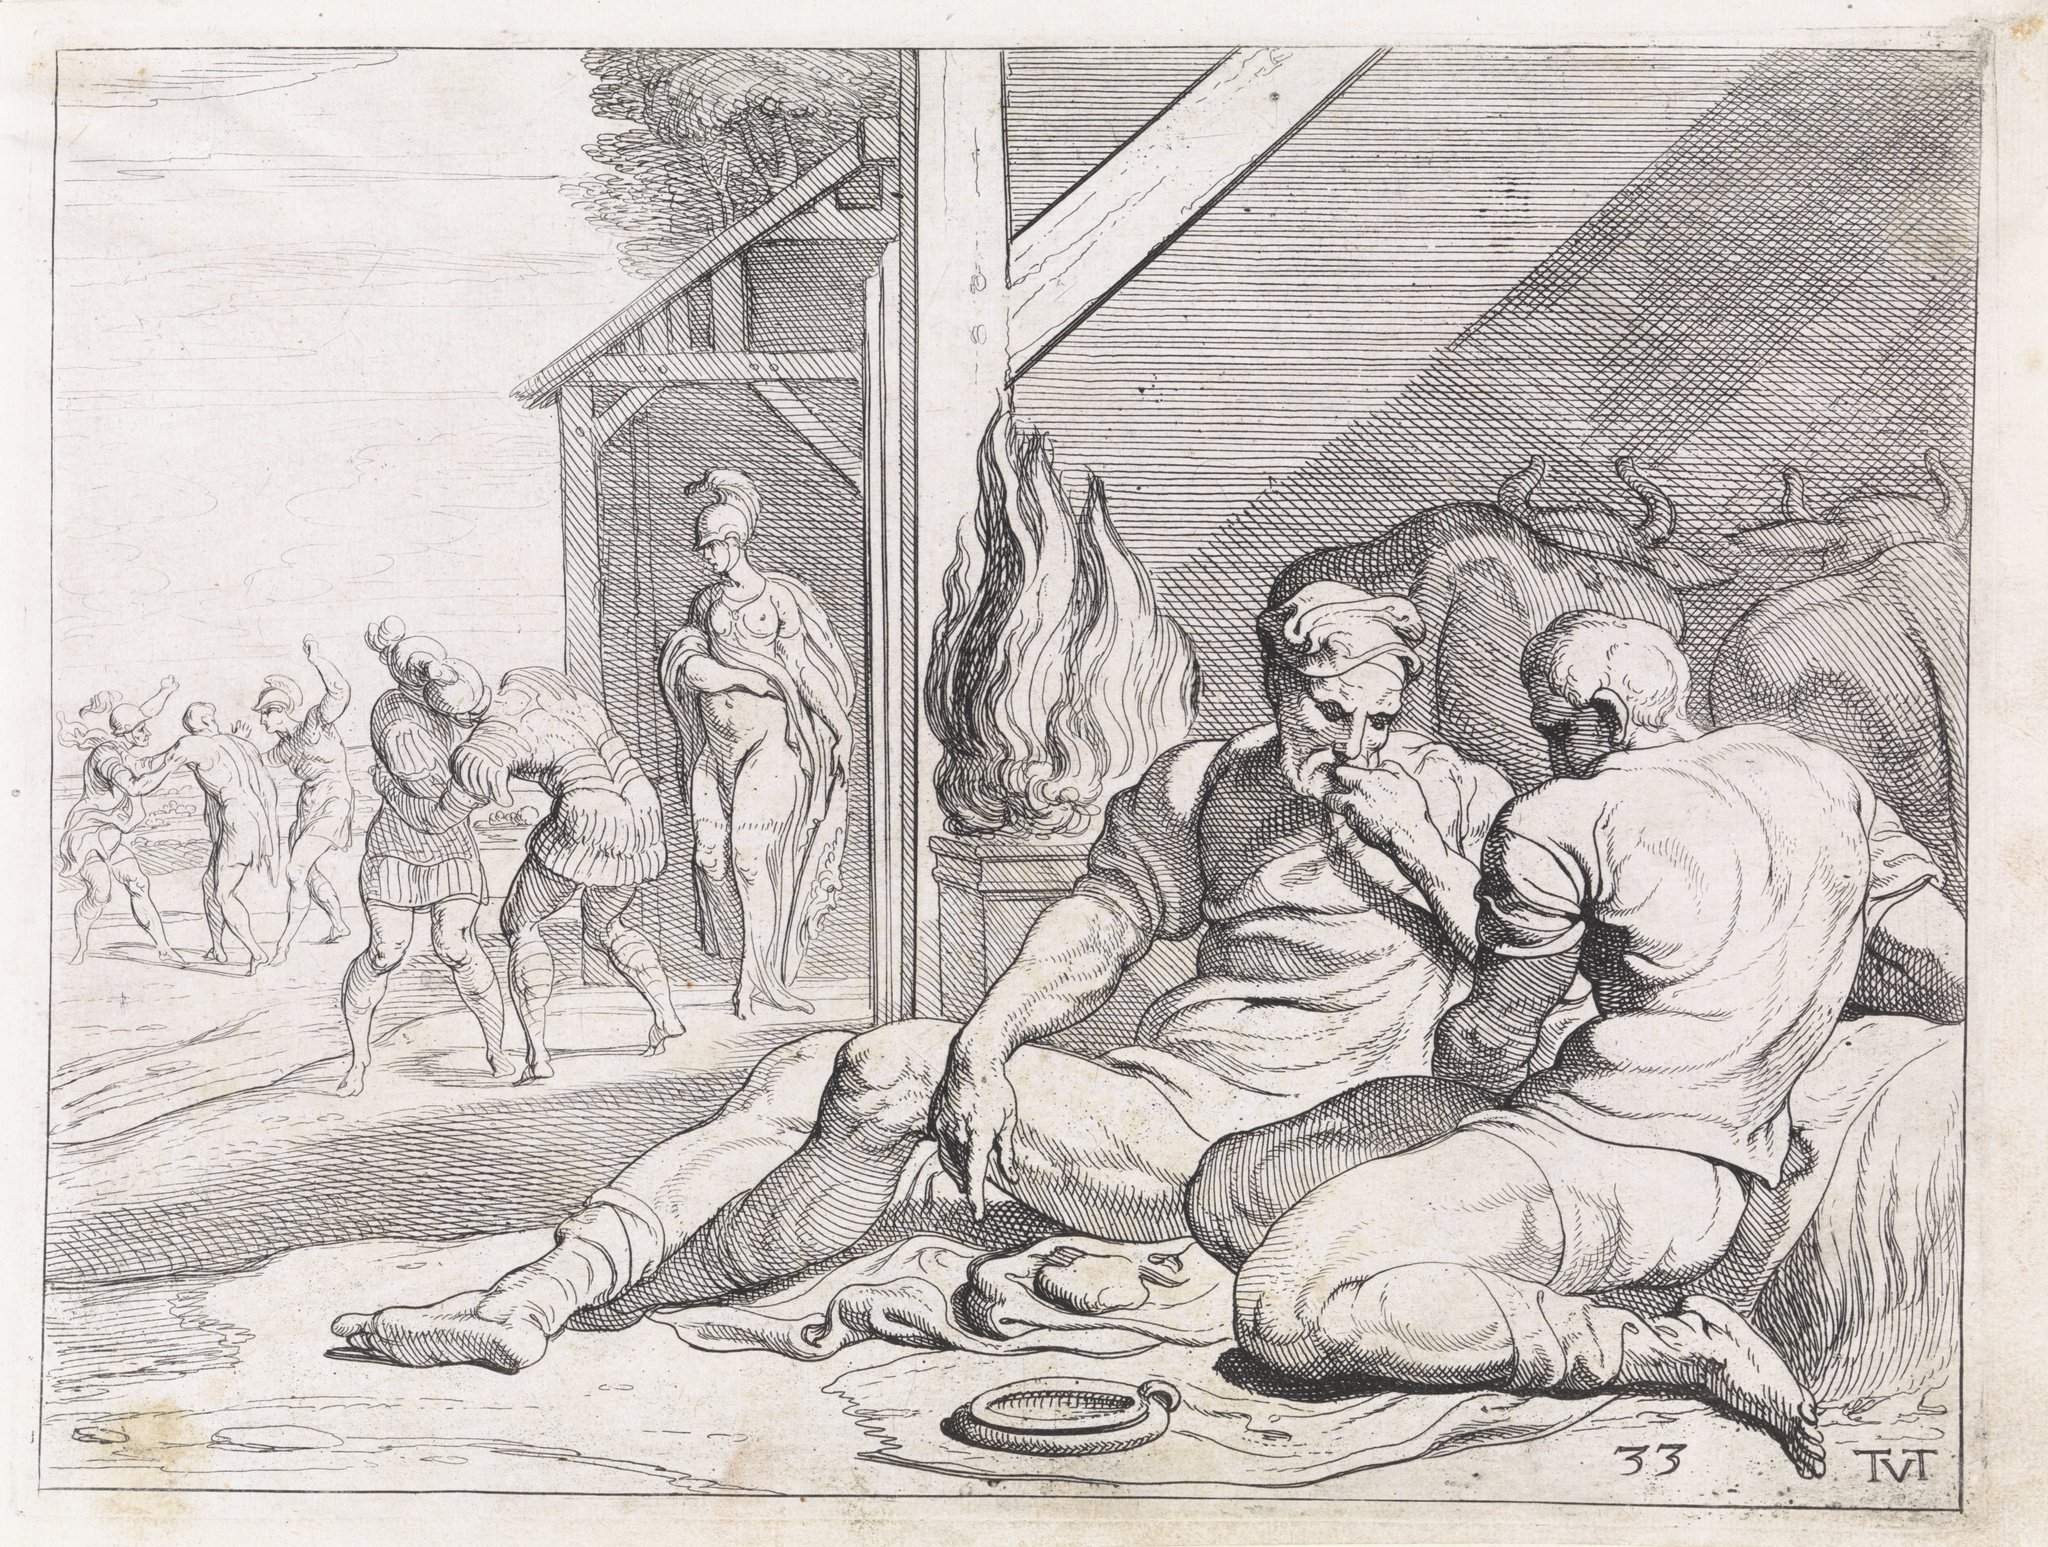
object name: print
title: De werken van Odysseus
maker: theodoor van thulden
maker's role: draughtsman, painter, print maker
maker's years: 1606-1669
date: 1632-1633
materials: paper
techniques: engraving, etching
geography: paris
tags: telemachus and ulysses meet in eumaeus' hut (homer, odyssey xvi)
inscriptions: collector's mark: Lugt 2228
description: Odysseus en Telemachus eten in de hut van de zwijnenhoeder Eumaeus. Bij de deur staat Minerva.